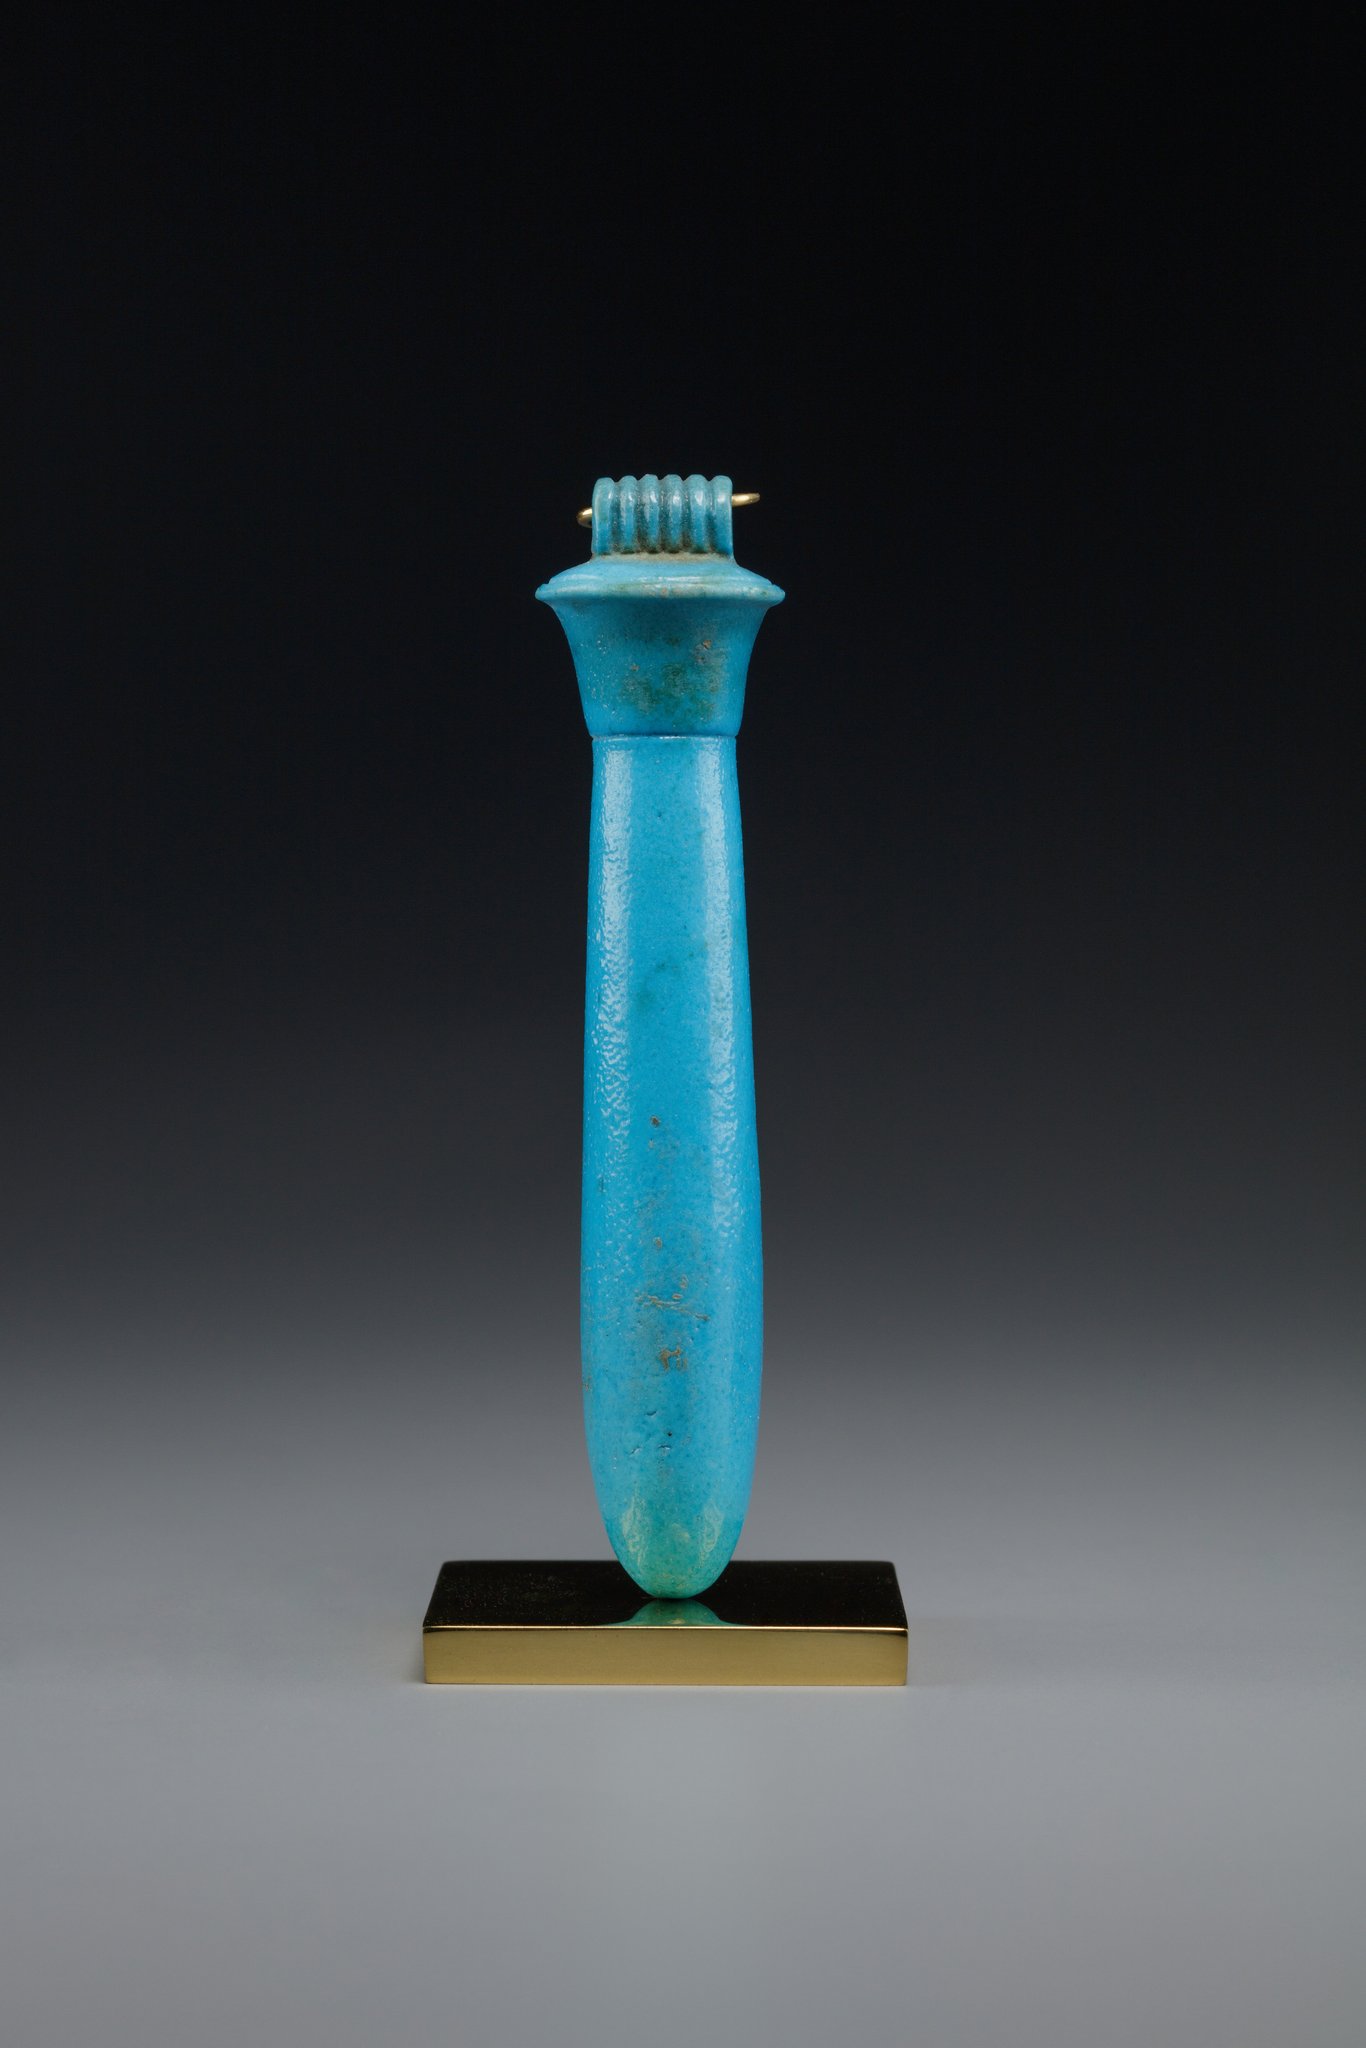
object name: pendant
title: Waz Amulet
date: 1295-1070 BCE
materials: faience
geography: egypt